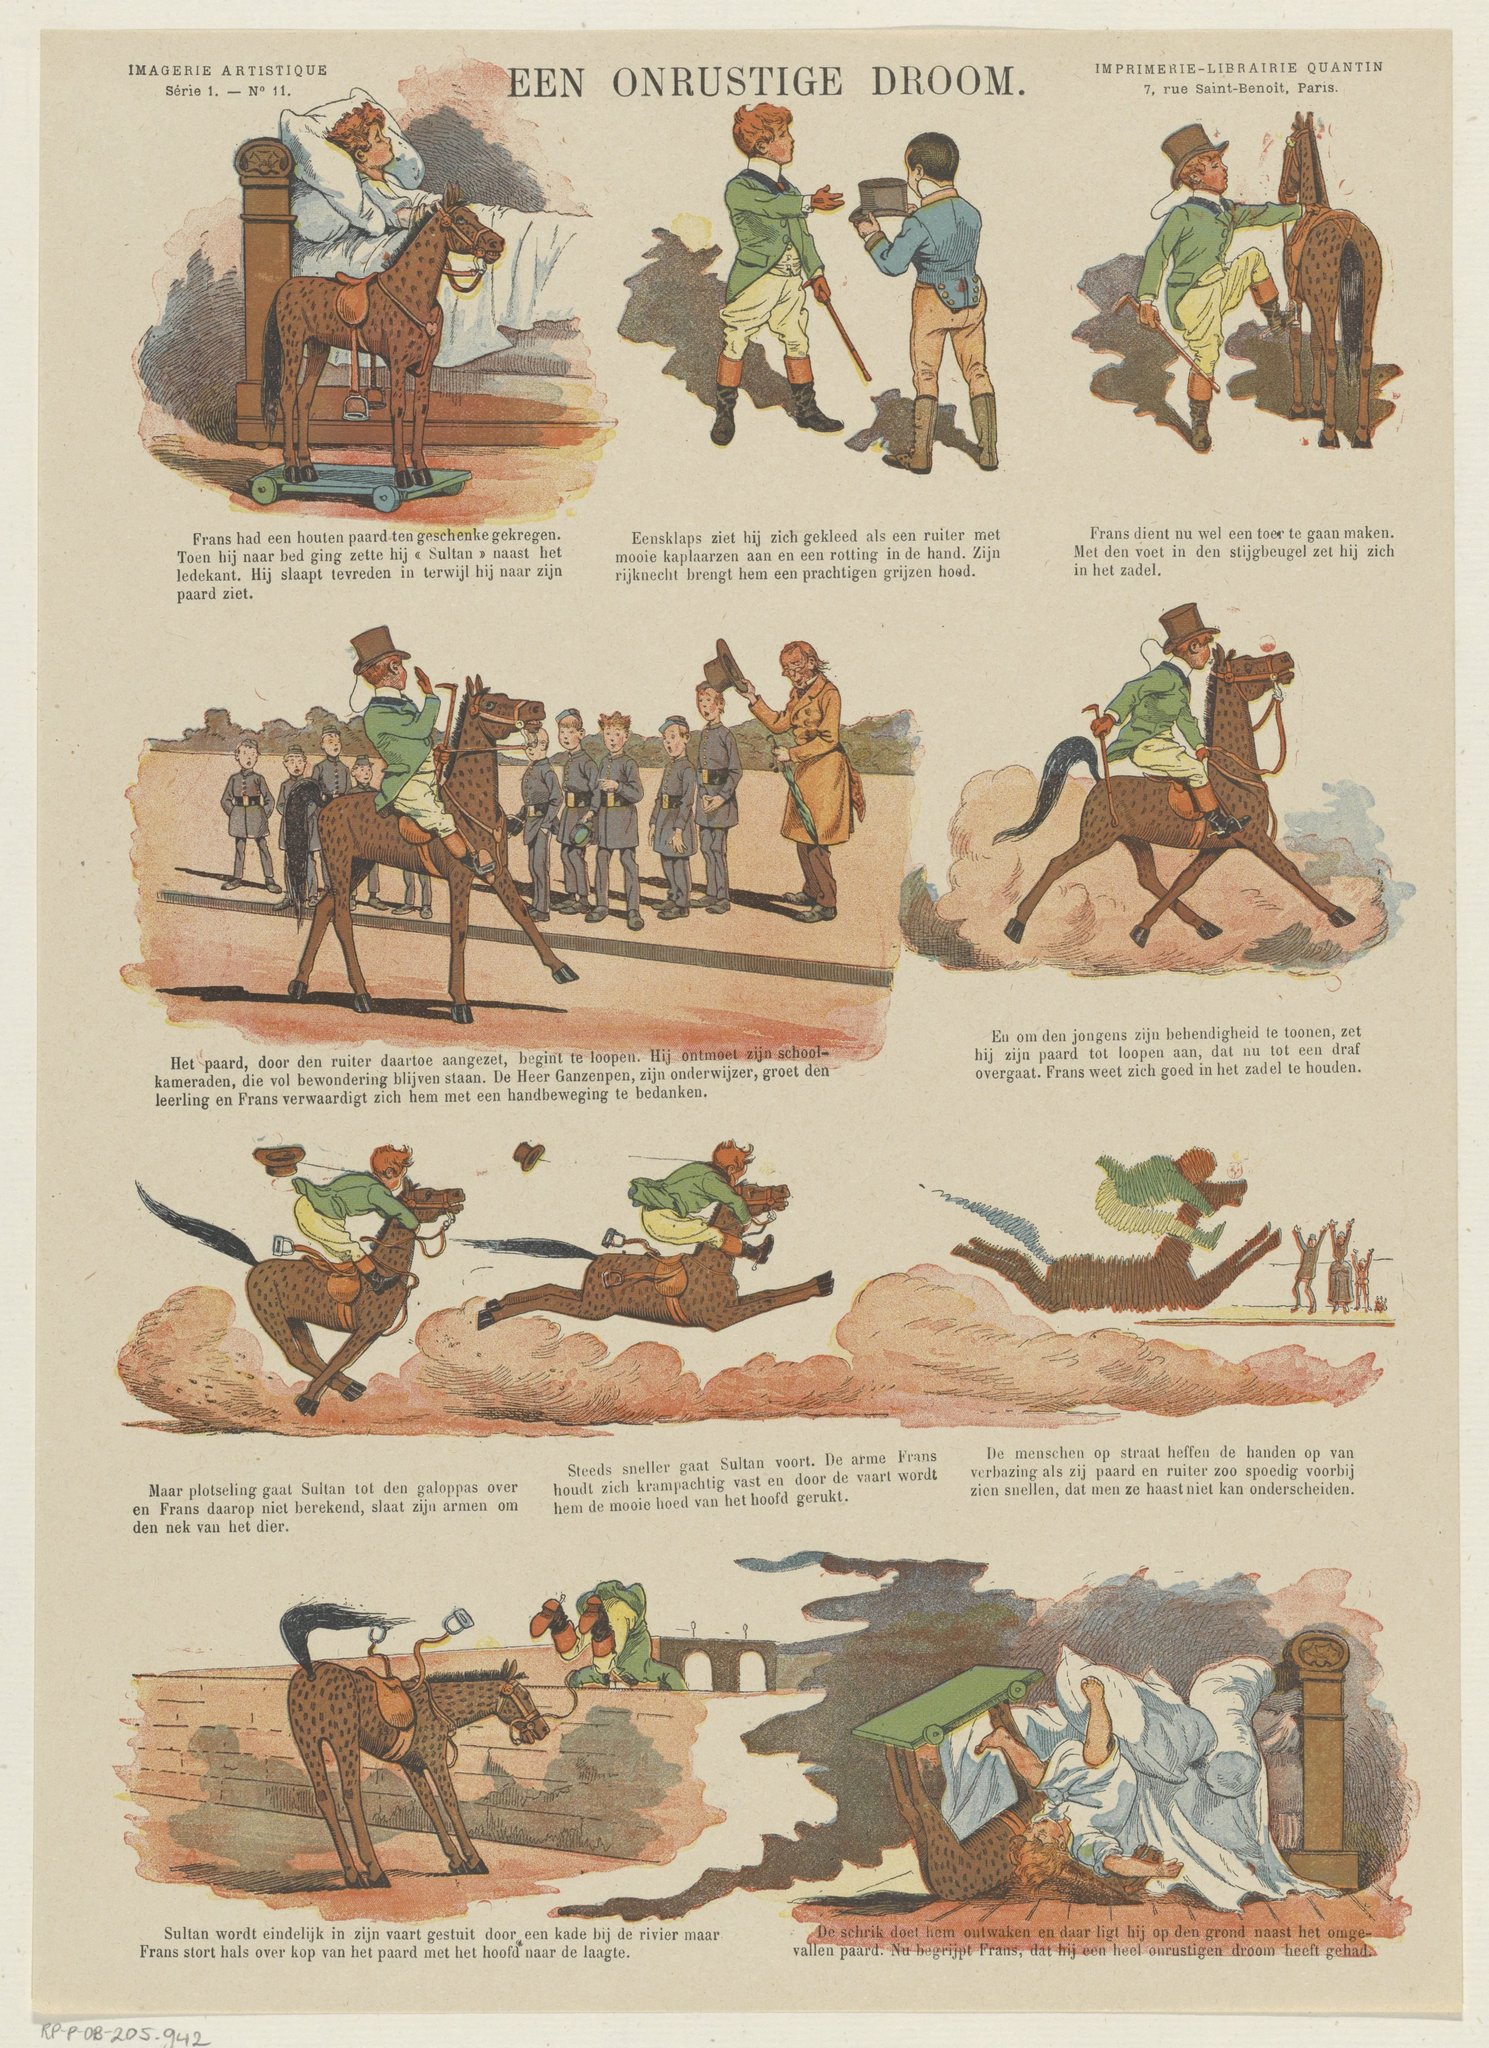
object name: print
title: Een onrustige droom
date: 1876-1890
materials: paper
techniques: lithograph, letterpress printing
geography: paris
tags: other movable toys, tales and fairy tales, dream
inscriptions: collector's mark: Lugt 2760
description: Blad met 10 voorstellingen van kleine Frans die droomt dat zijn speelgoedpaard tot leven komt. Onder elke voorstelling een onderschrift. Genummerd linksboven: Série 1. - No. 11.